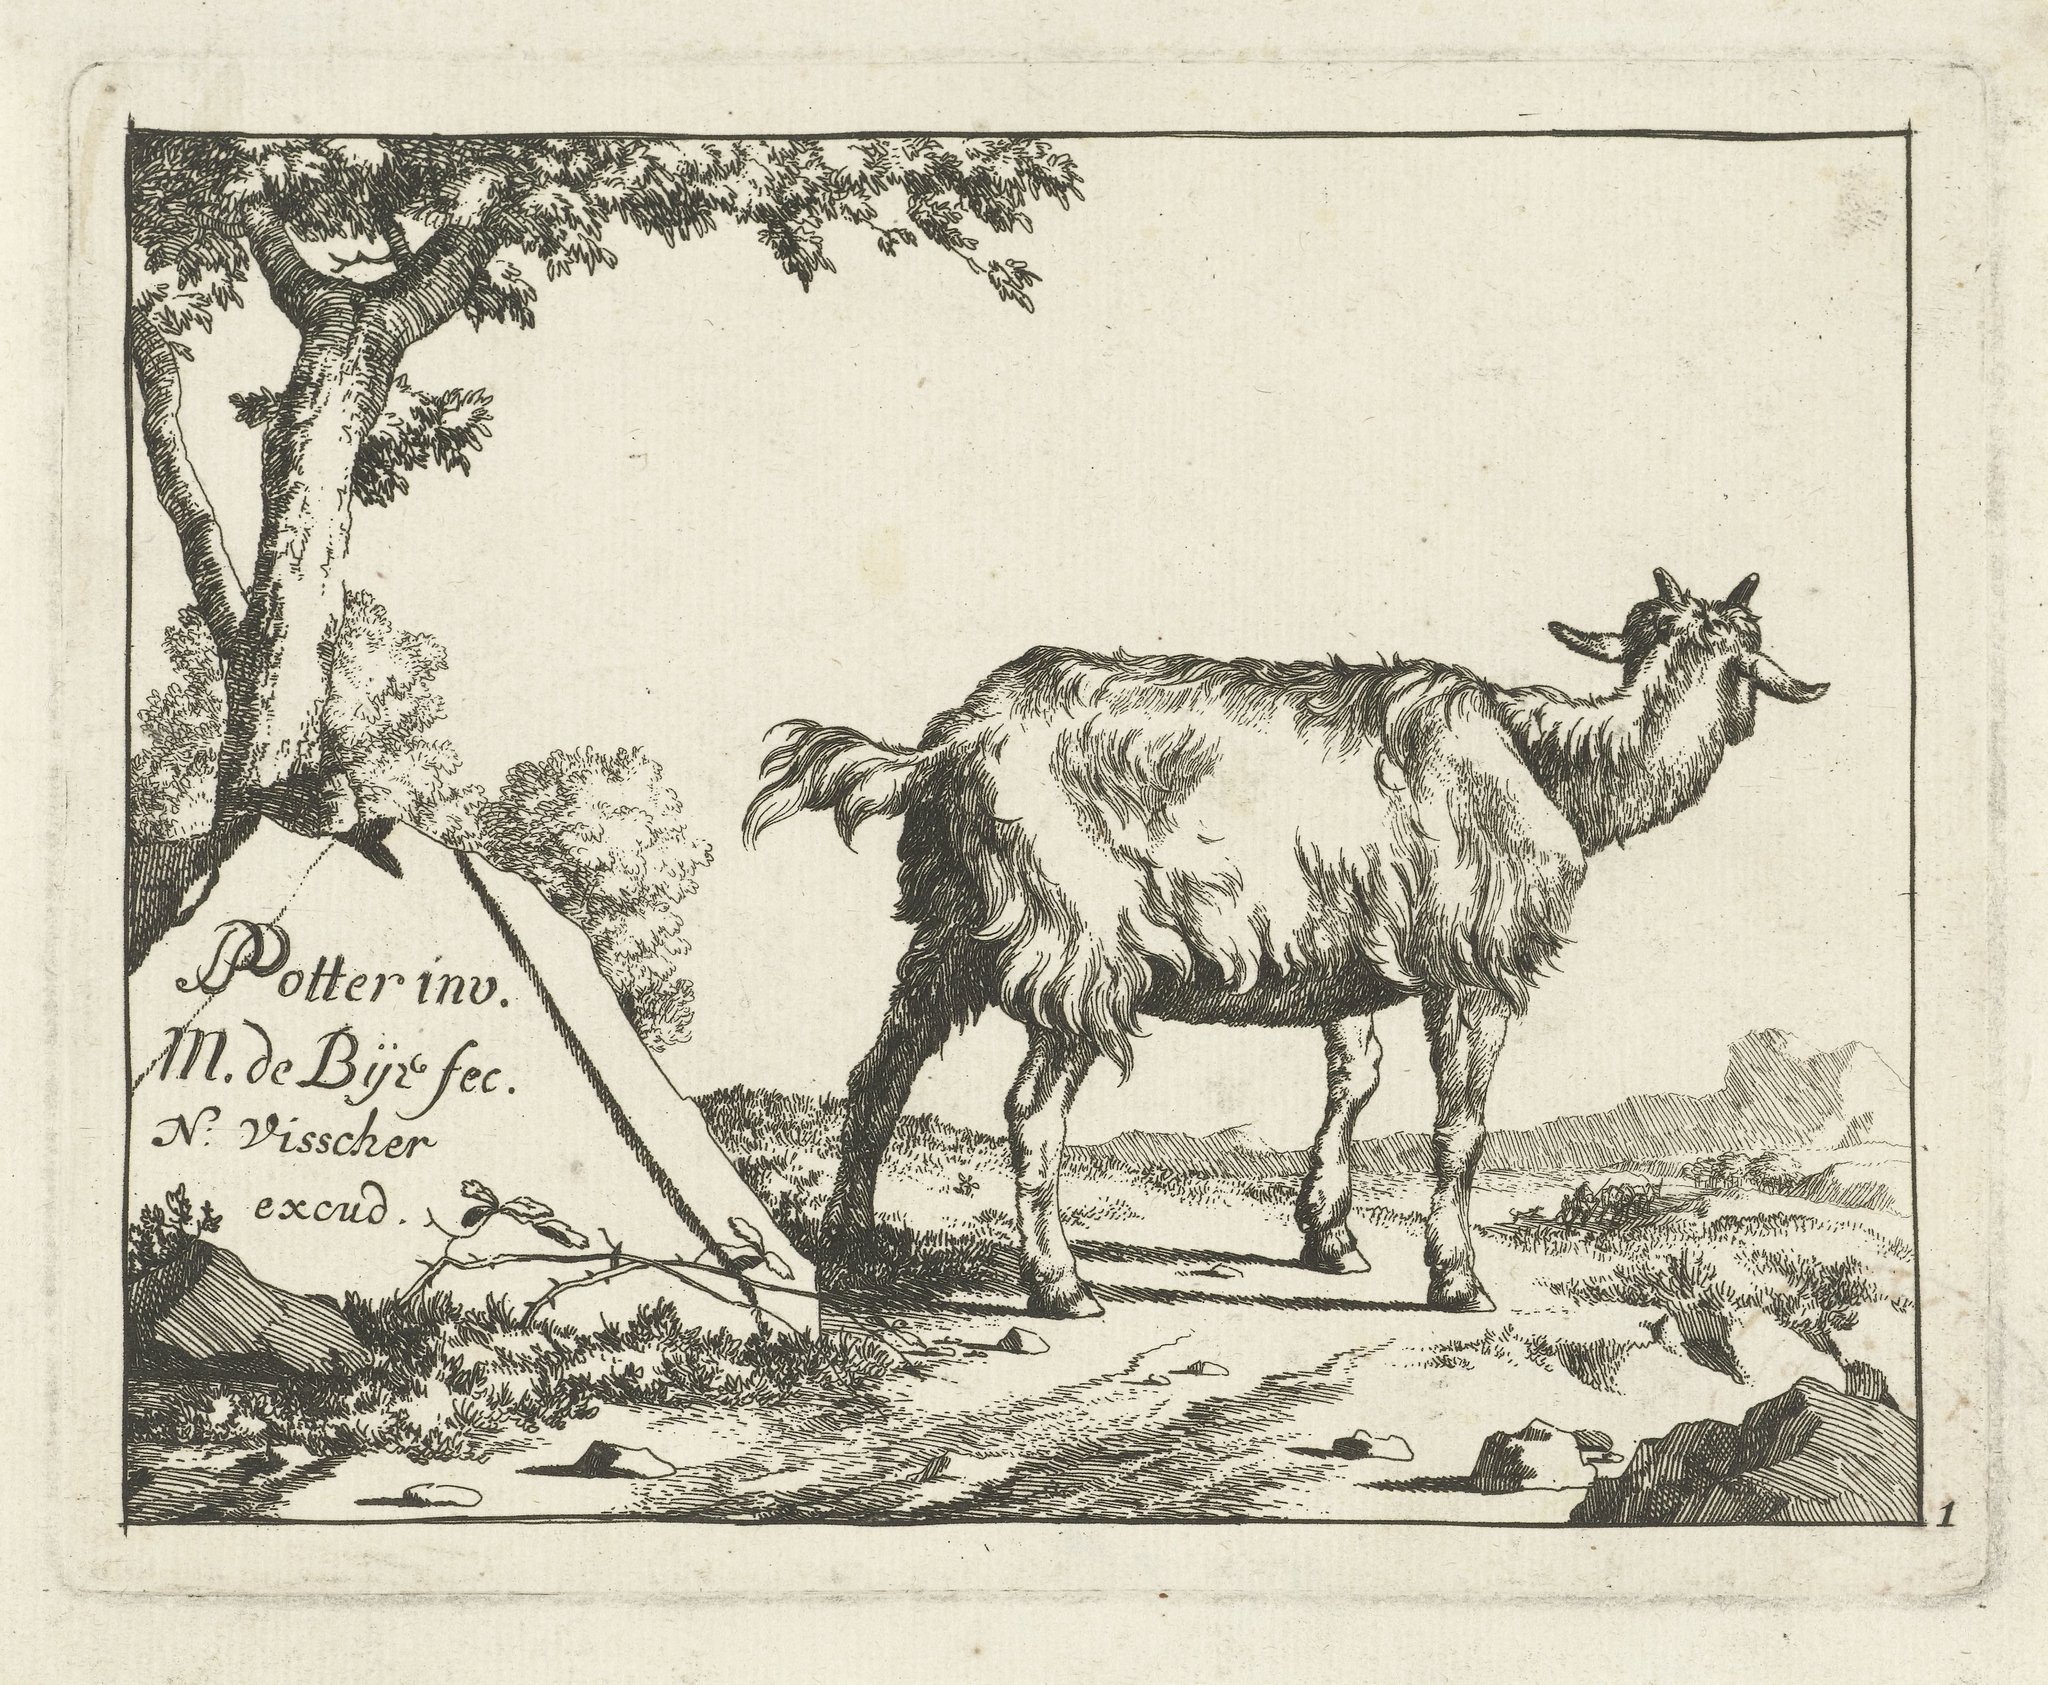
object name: titelprent, frontispice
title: Staande geit van achter gezien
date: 1657-1677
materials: paper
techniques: etching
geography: amsterdam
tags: goat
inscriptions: collector's mark: Lugt 240